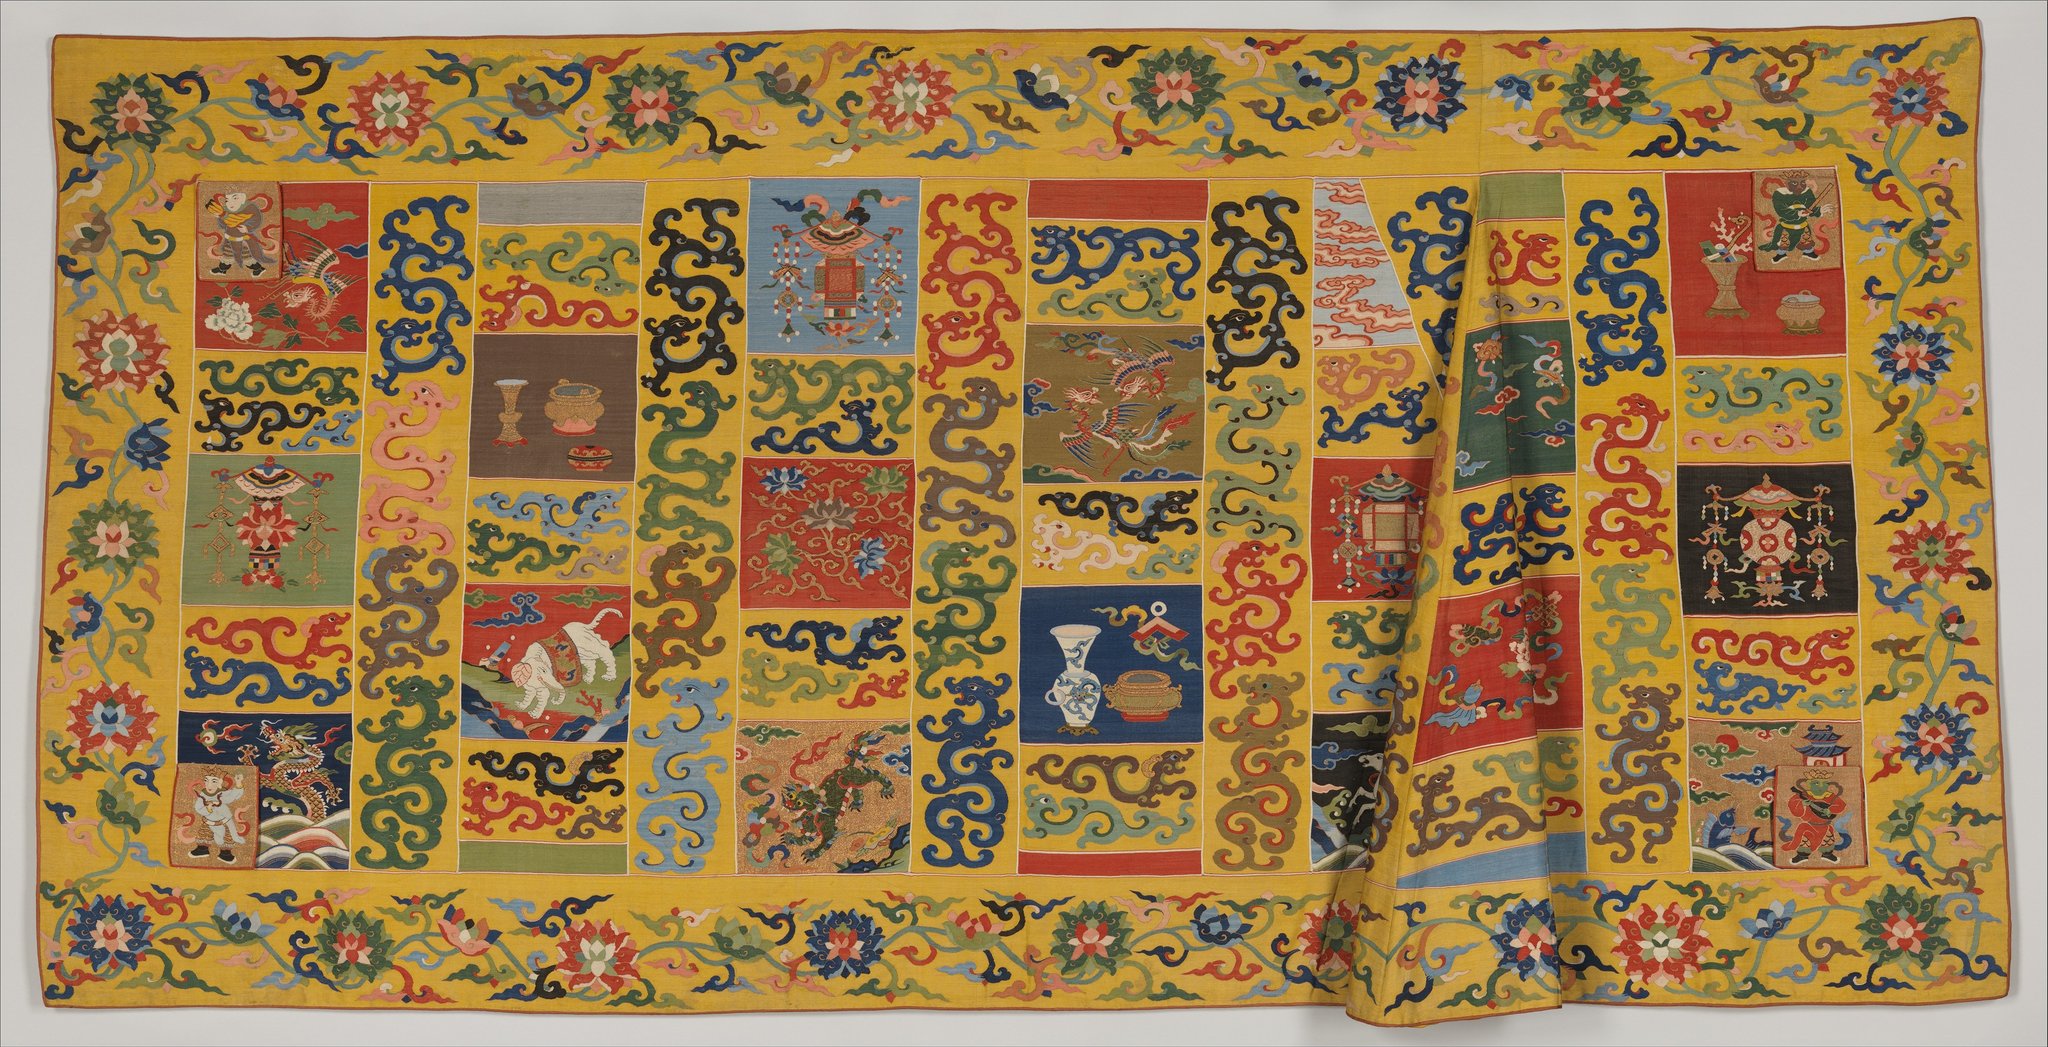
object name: buddhist priest's robe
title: Theatrical Costume for the Role of a Buddhist Cleric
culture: chinese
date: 1662-1722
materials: feather, metal thread, silk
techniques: tapestry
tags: costumes,dragons,elephants